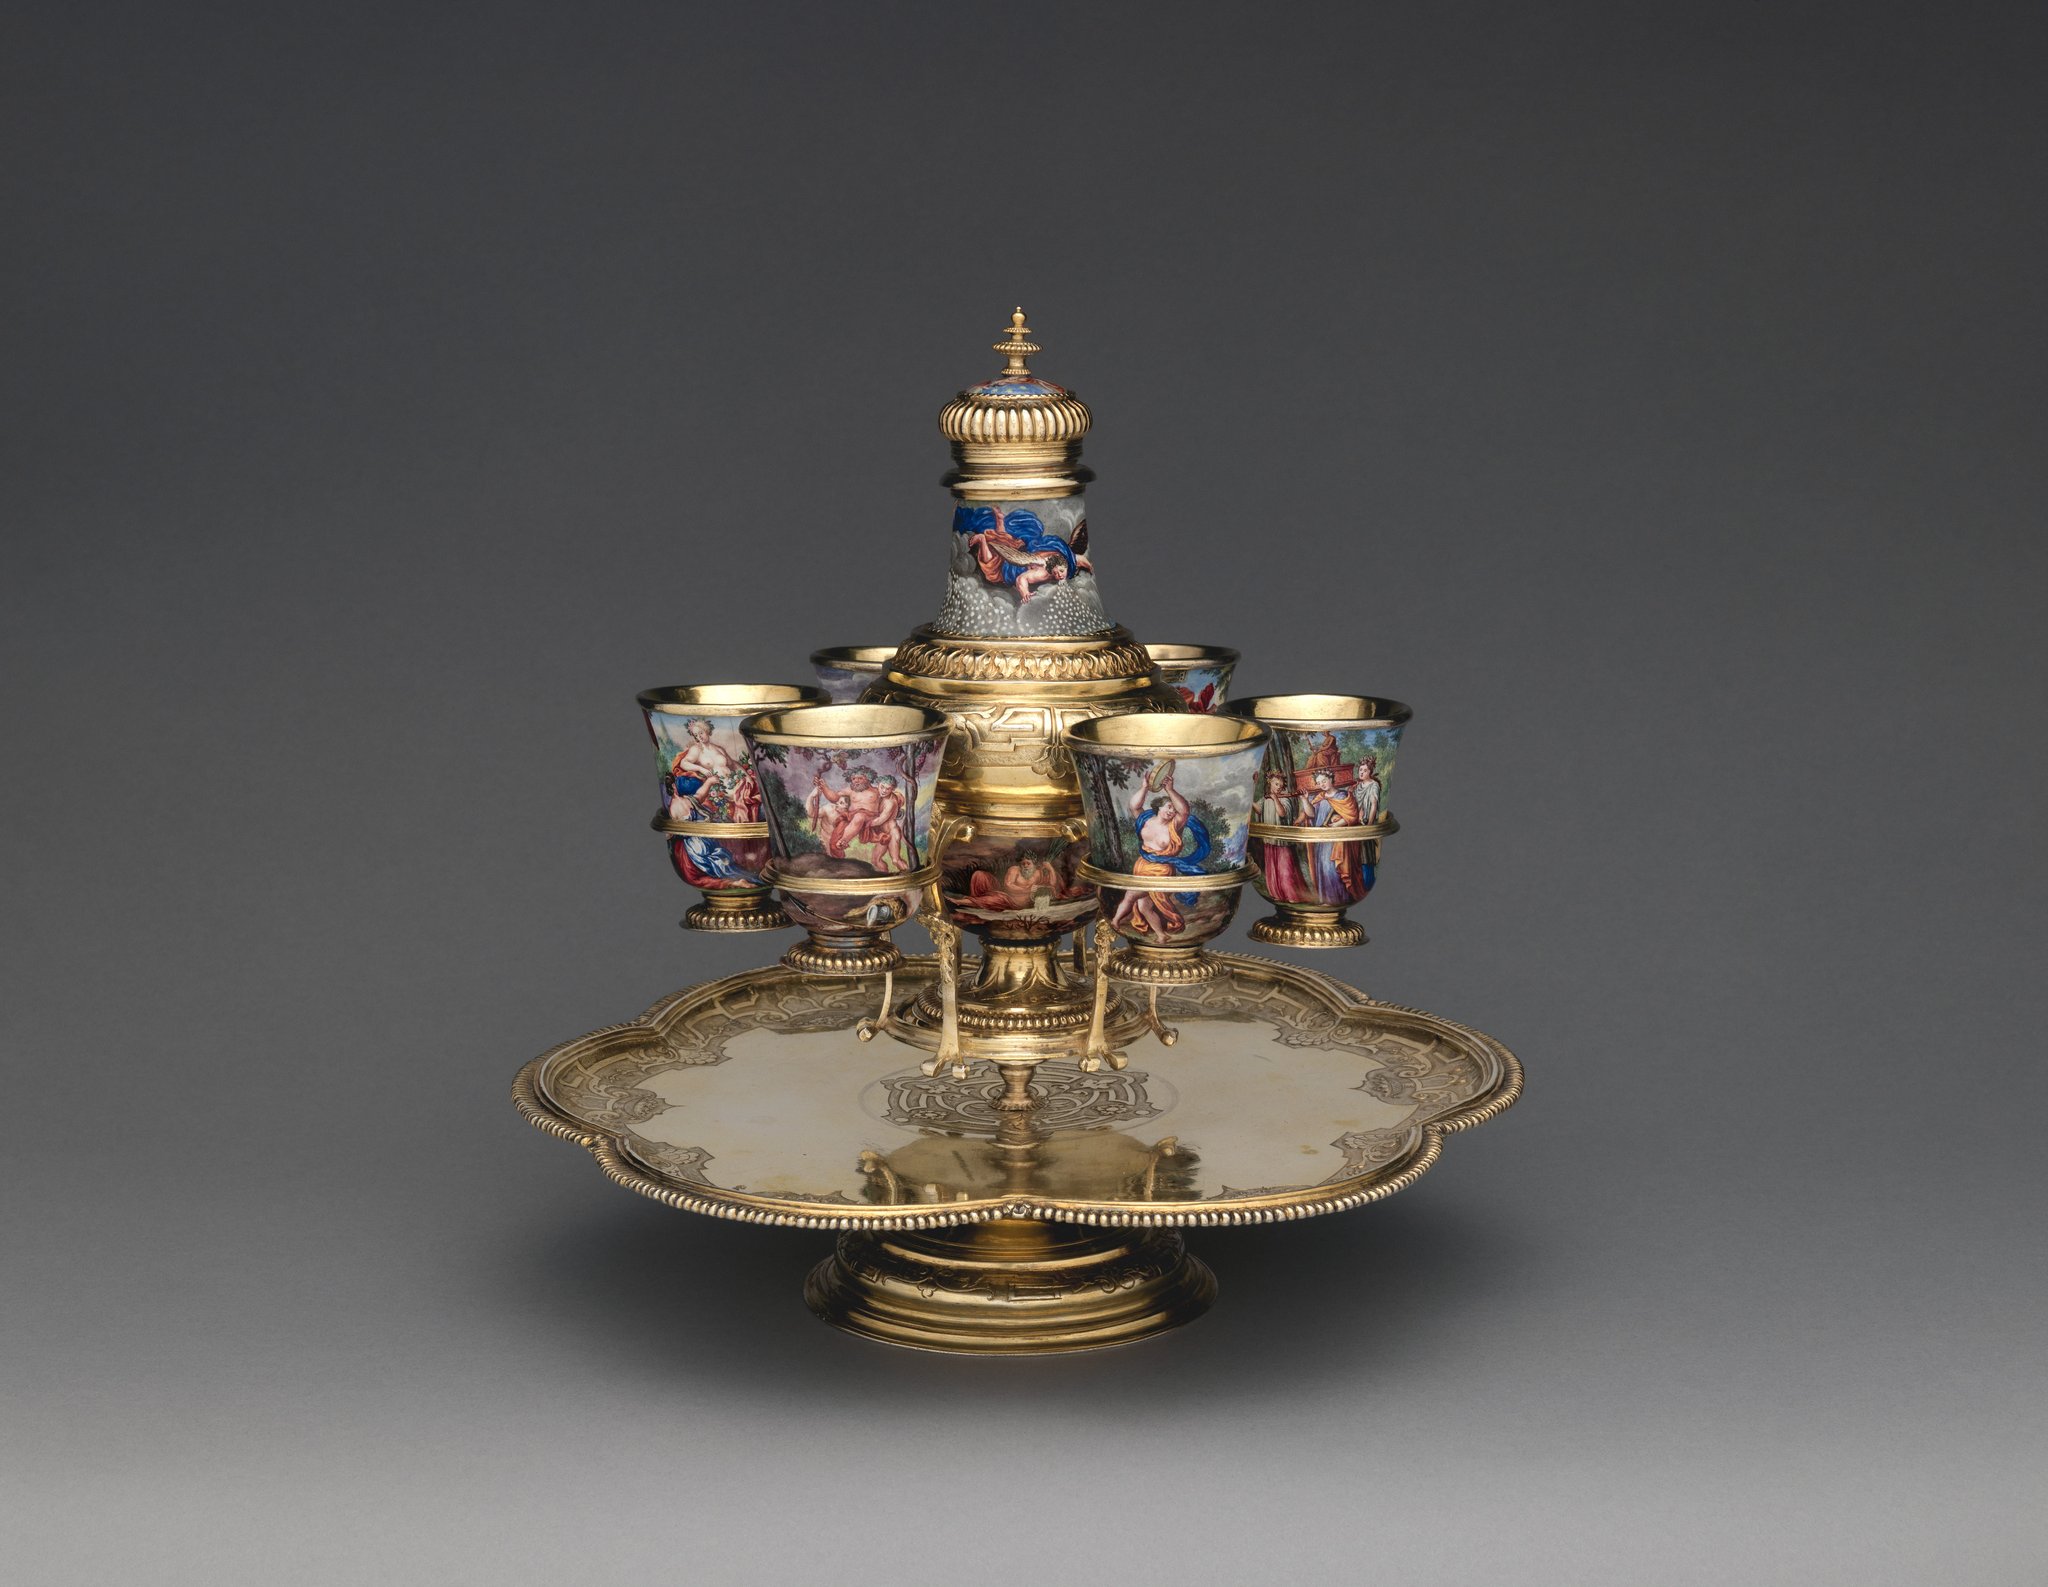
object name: service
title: "Four Seasons" enamel liqueur service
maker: elias adam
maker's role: silversmith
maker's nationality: german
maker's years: 1669-1745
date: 1710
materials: copper, enamel, silver gilt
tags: men,female nudes